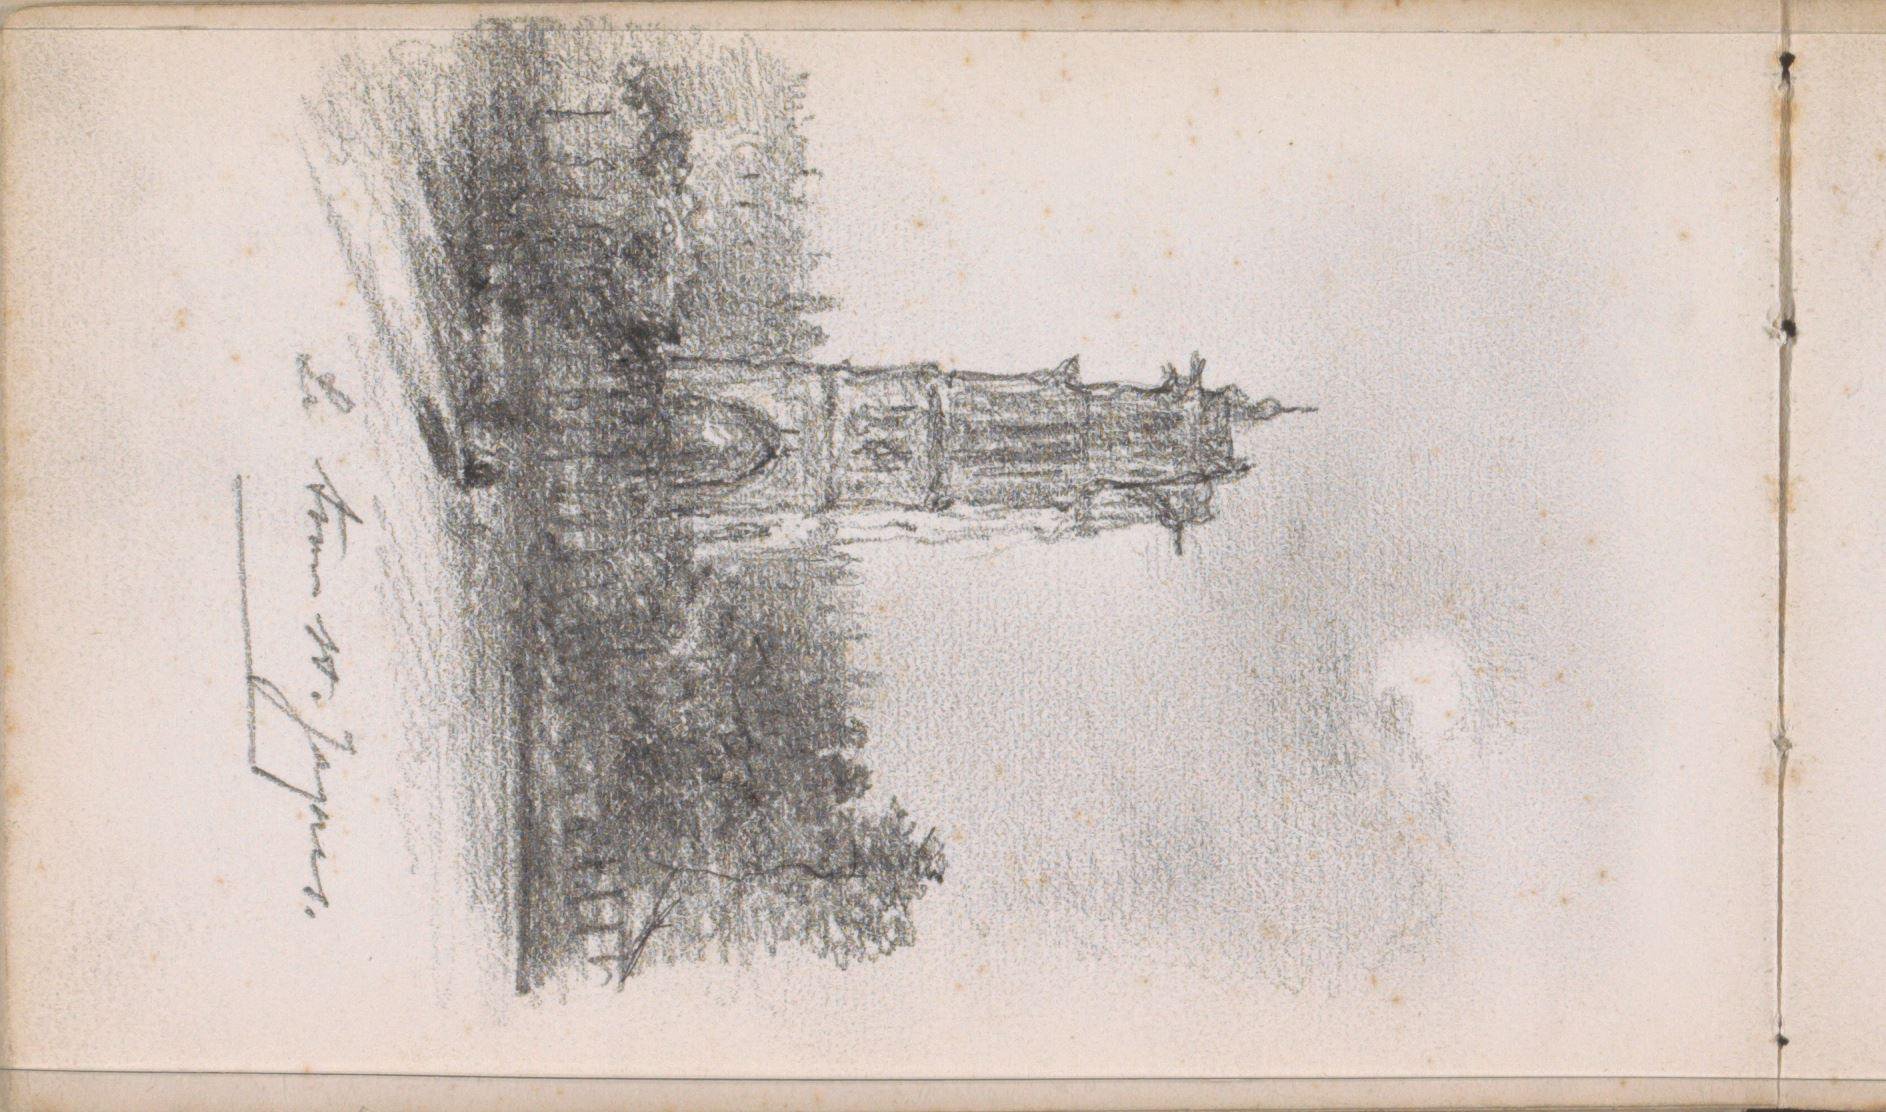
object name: sketchbook leaf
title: Tour Saint-Jacques te Parijs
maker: maria vos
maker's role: draughtsman, painter, print maker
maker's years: 1824-1906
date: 1811-1867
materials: paper, pencil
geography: paris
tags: parts of church exterior and annexes: tower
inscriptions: annotation: ‘Le tour st. Jaques’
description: Blad 27 verso uit een schetsboek met 40 bladen.